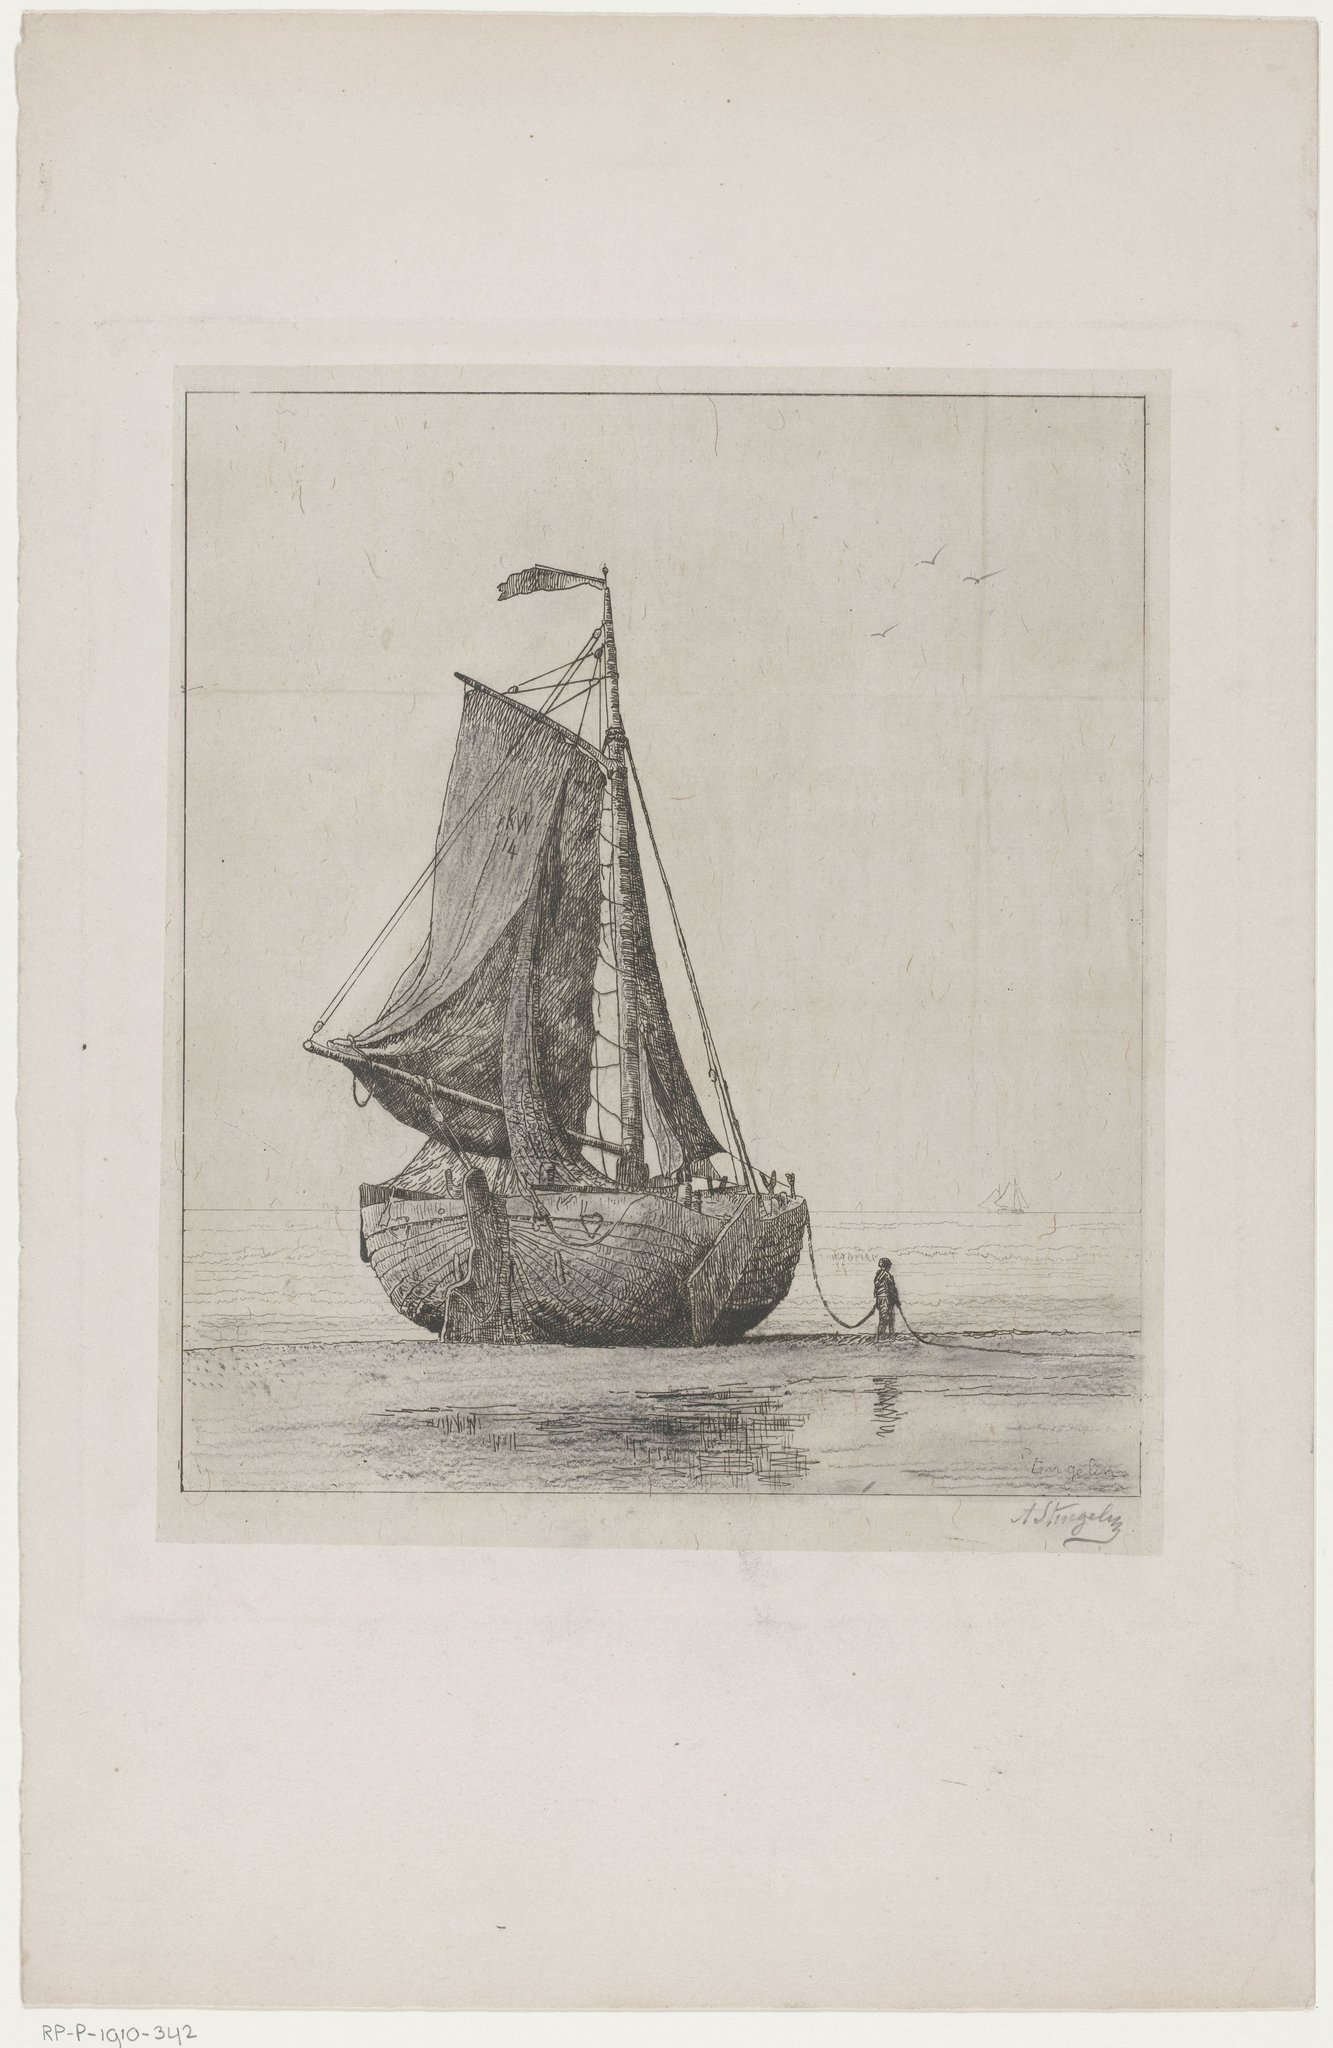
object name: print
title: Vissersboot op het strand van Katwijk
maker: alphonse stengelin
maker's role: painter, print maker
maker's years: 1852-1938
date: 1862-1910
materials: paper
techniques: aquatint, etching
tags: commercial fishery, sailing-ship, sailing-boat, coast, sea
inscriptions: collector's mark: Lugt 2228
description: Naast de boot een zeeman die de ankerketting draagt.